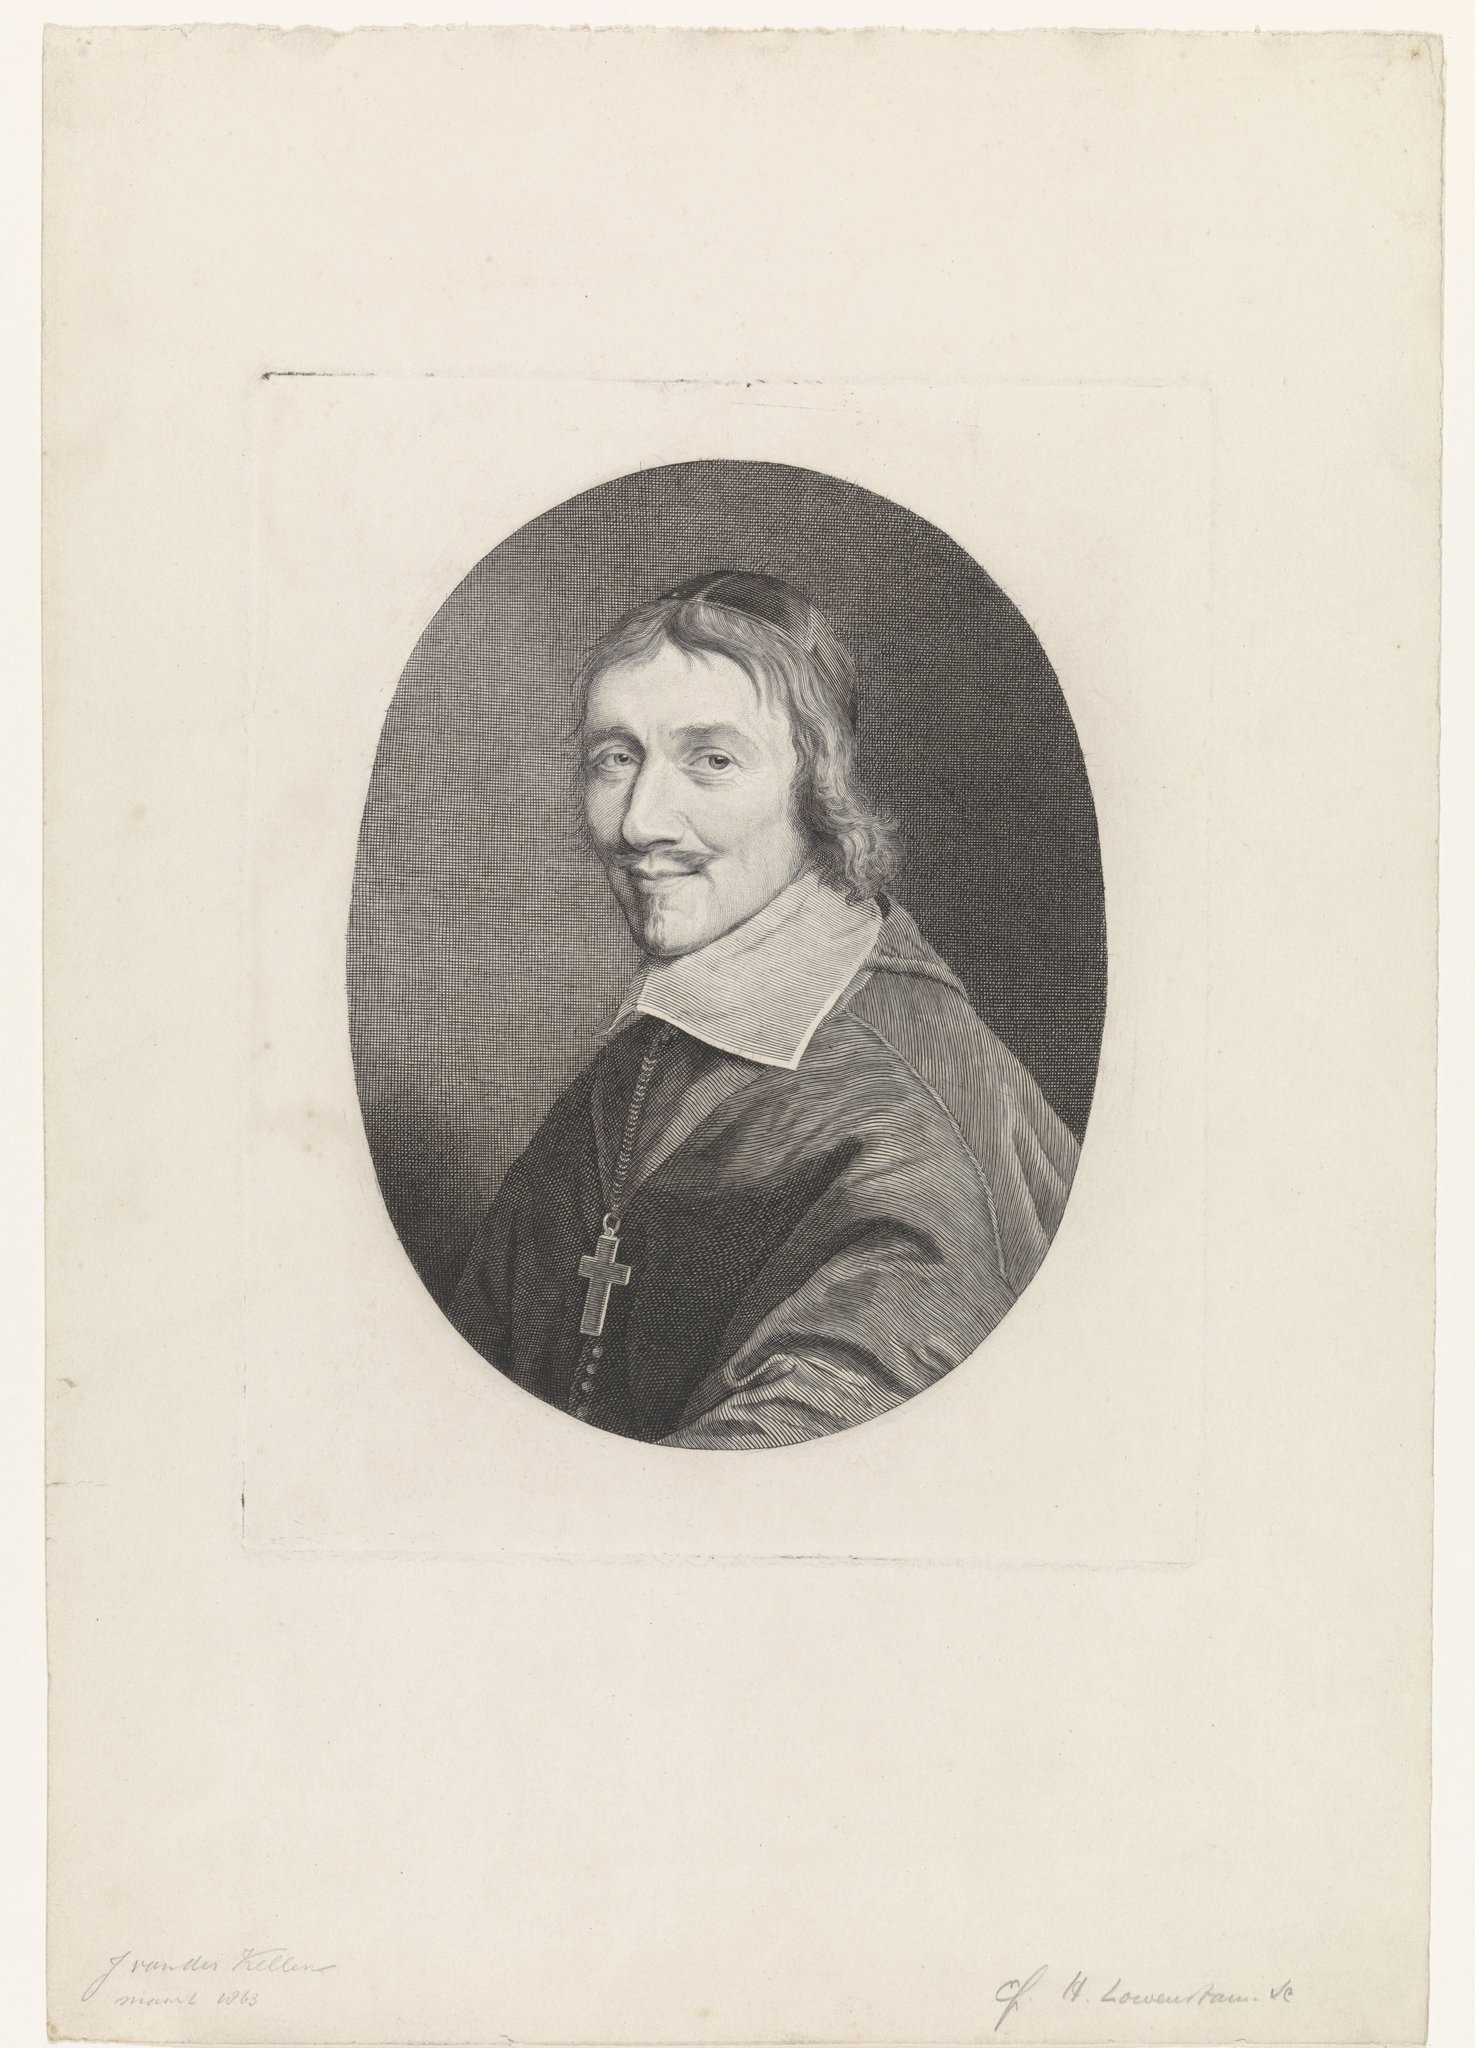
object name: print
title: Portret van een geestelijke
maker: johannes van der kellen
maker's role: print maker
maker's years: 1843-1895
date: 1863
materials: paper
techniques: engraving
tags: adult man, organization, functionaries and dignitaries in roman catholic church; clergy in general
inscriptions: inscription: ‘J vander Kellen maart 1863 cf H. Lowerstam. (...)’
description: Busteportret in een ovaal naar links van een geestelijke met om zijn hals een kruis. Zijn hoofd is getooid met een kalot.